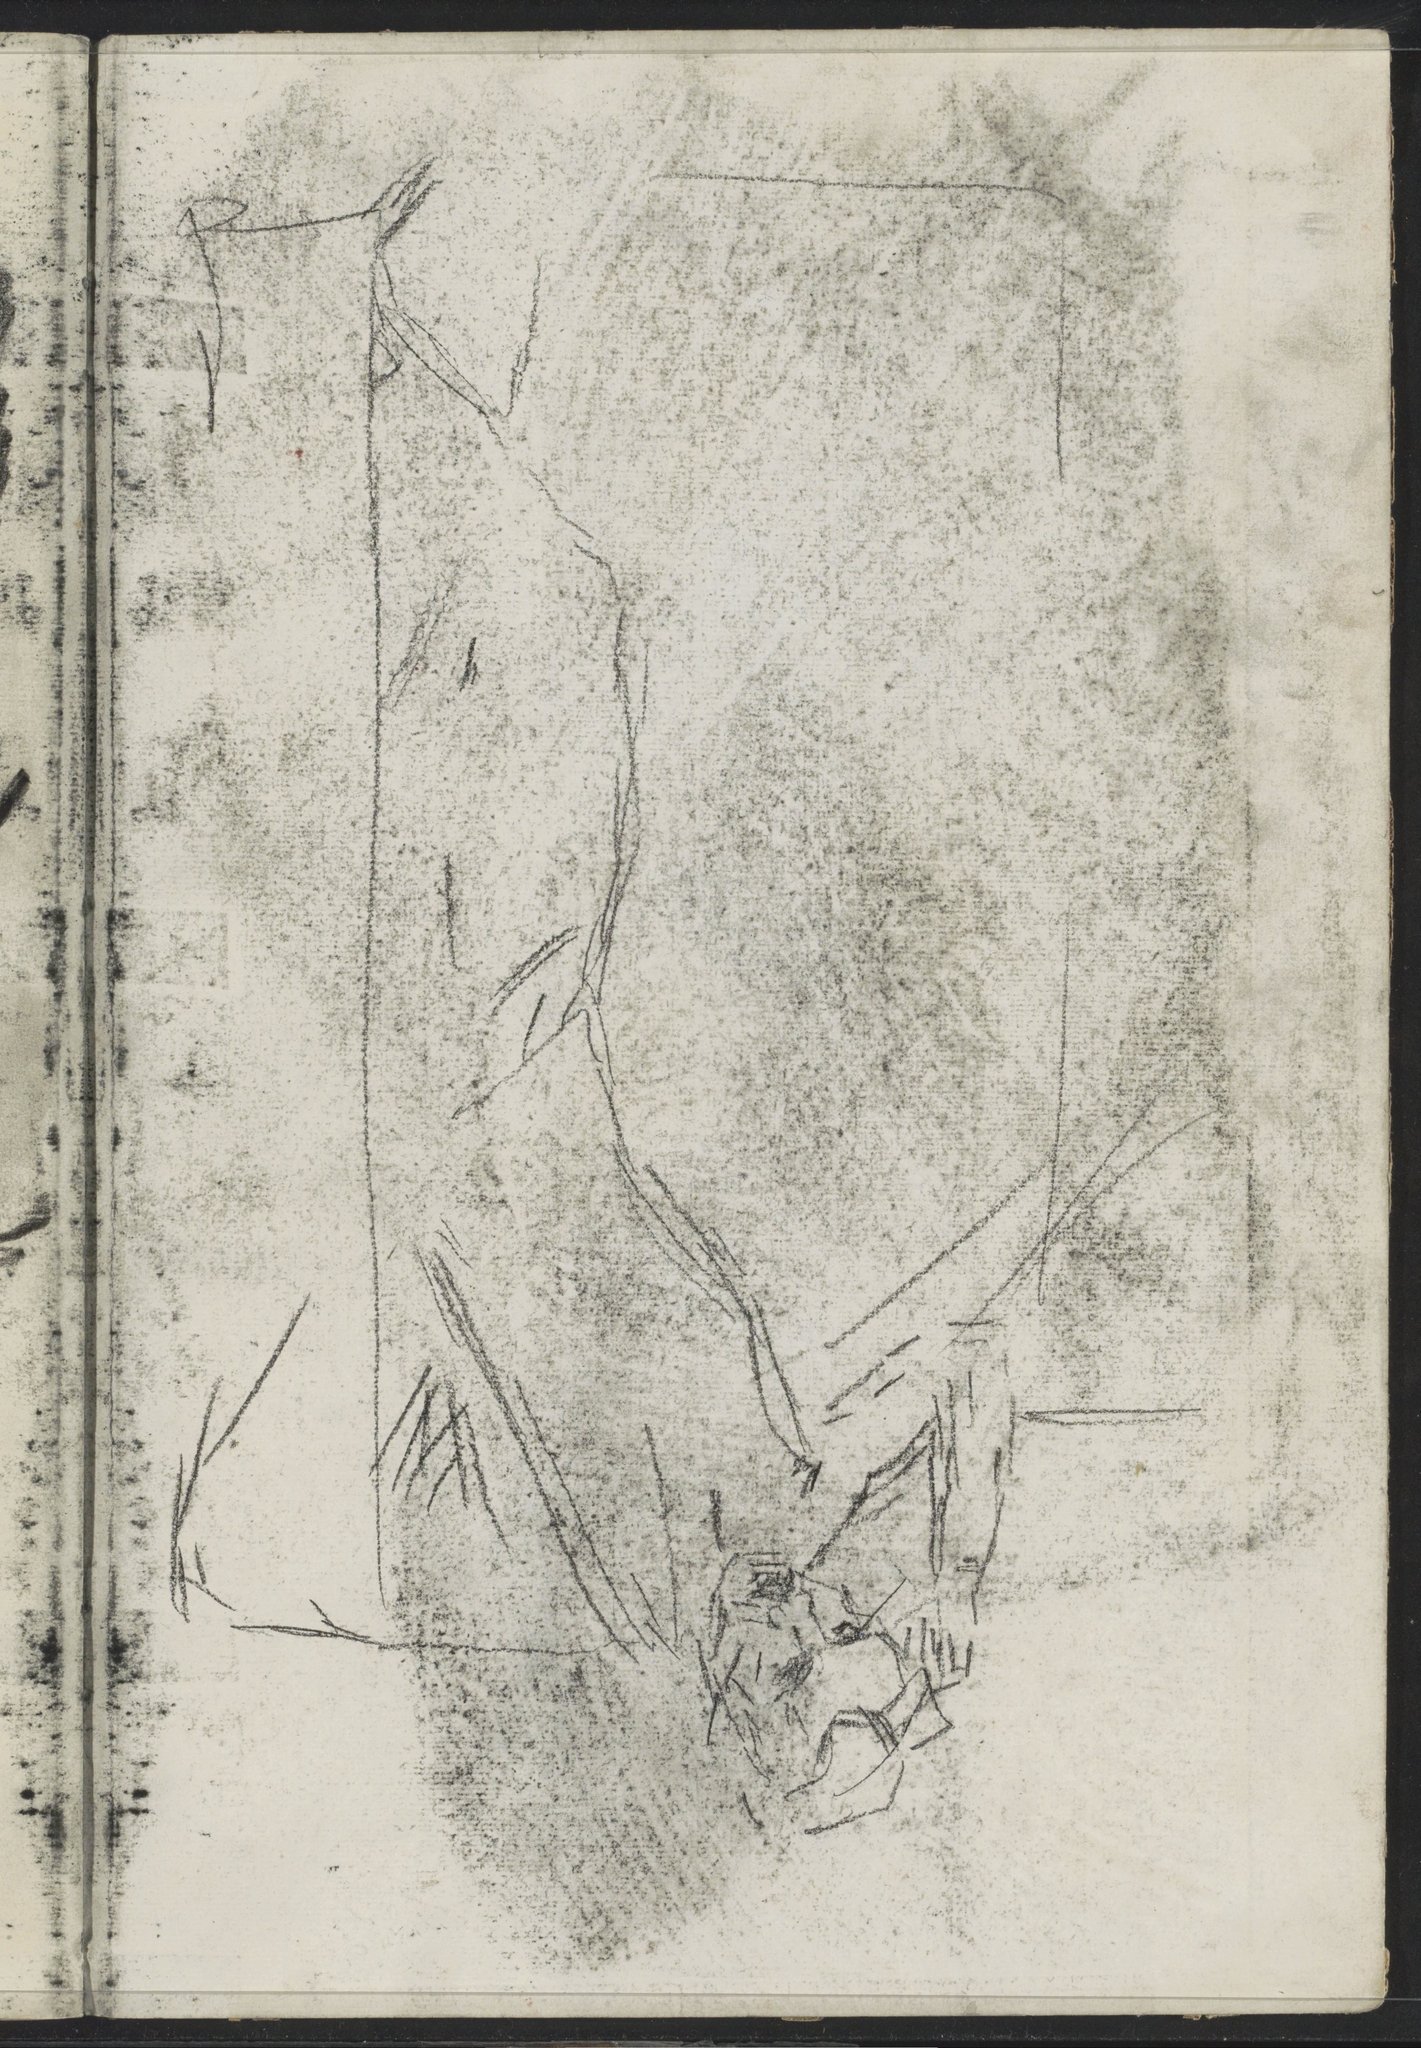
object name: endleaf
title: Leunende man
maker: isaac israels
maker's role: draughtsman, painter, print maker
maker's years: 1865-1934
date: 1875-1934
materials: chalk, paper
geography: the hague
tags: adult man (+ leaning), cupboard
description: De man staat bij een kast en steunt op één elleboog. Zijn andere hand heeft hij in zijn zij. Schutblad B, achterste schutblad, uit schetsboek LXVIII met 11 bladen.